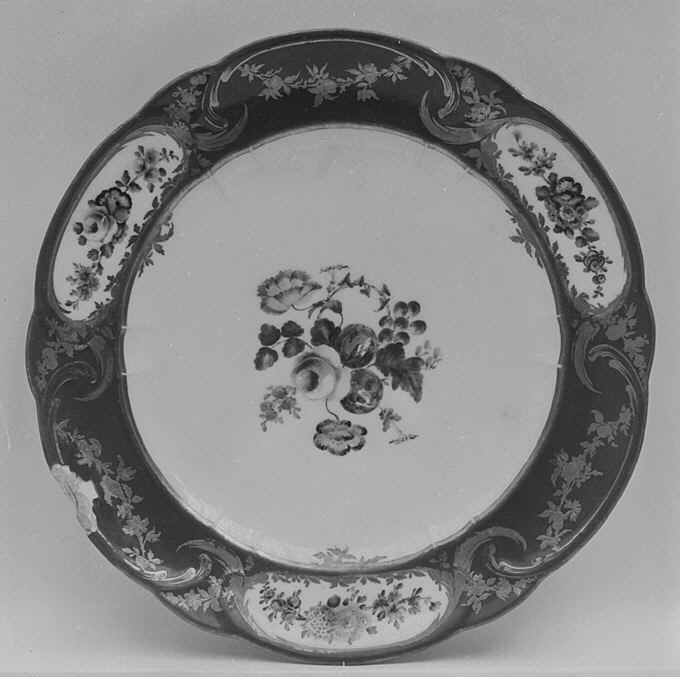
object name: plate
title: Plate (assiette à palmes) (1 of 102) (part of a service)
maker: sèvres manufactory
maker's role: manufactory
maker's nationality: french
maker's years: 1740-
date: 1767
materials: soft paste porcelain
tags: flowers